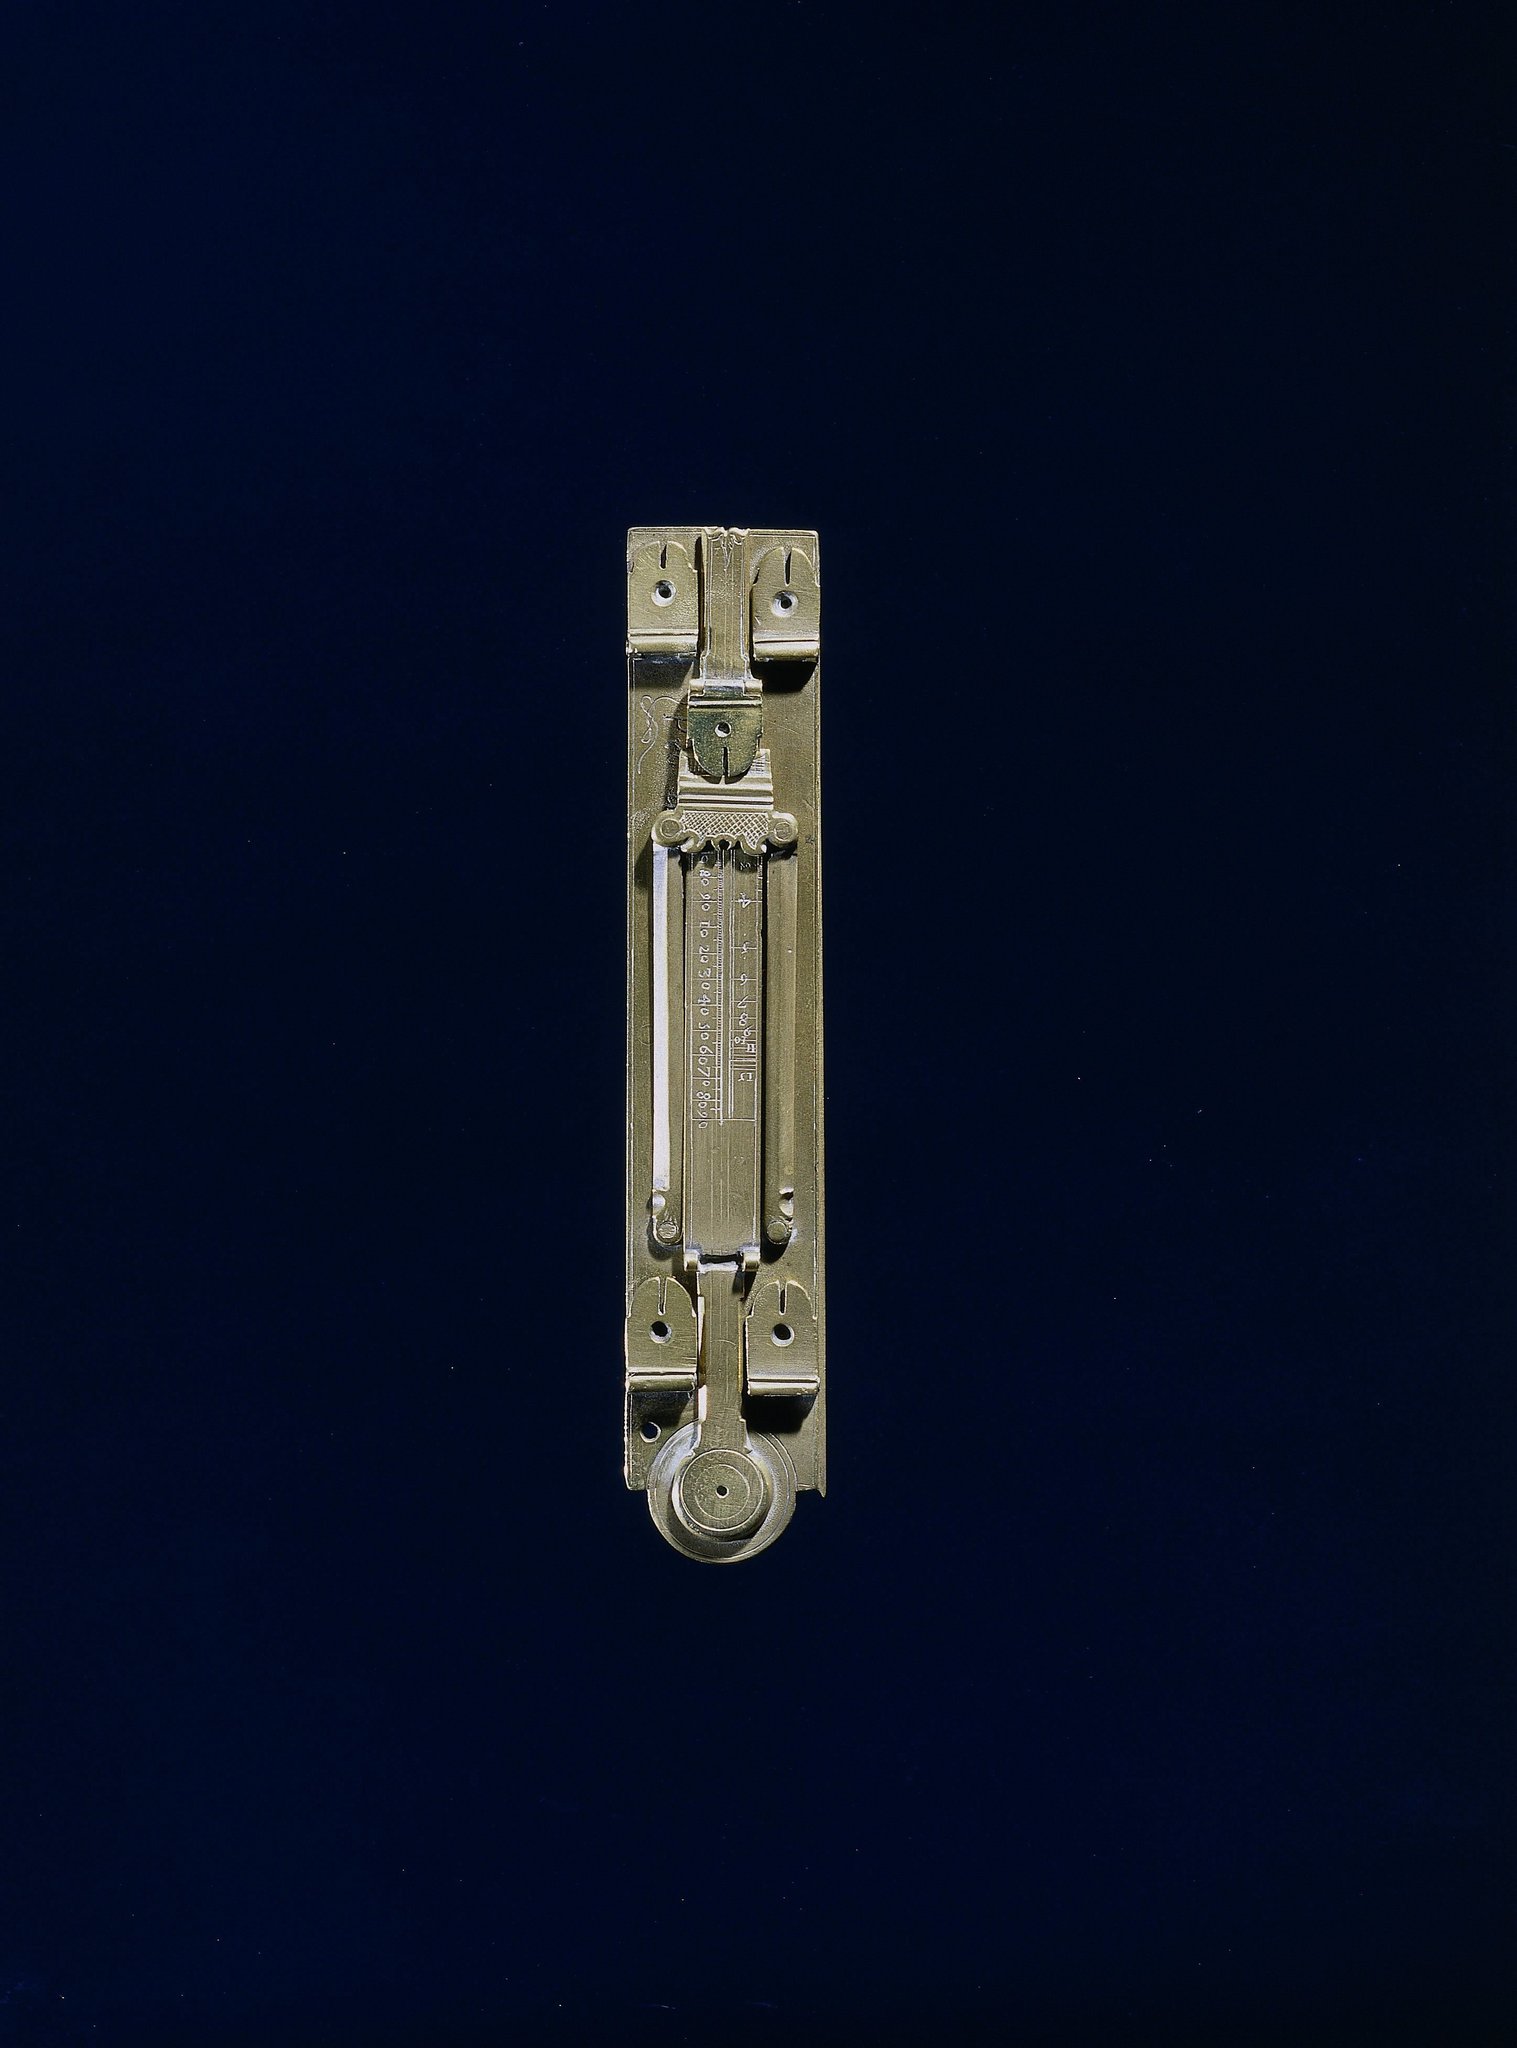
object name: angle measuring device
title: Hoekmeter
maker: Anonymous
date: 1582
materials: brass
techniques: casting, engraving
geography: western europe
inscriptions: inscription: ‘Pro declinatione muri’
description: Goniometer (surveyor's instrumentfor measuring angles). Brass. Western Europe, 1582. On loan from the Royal Antiquarian Society.